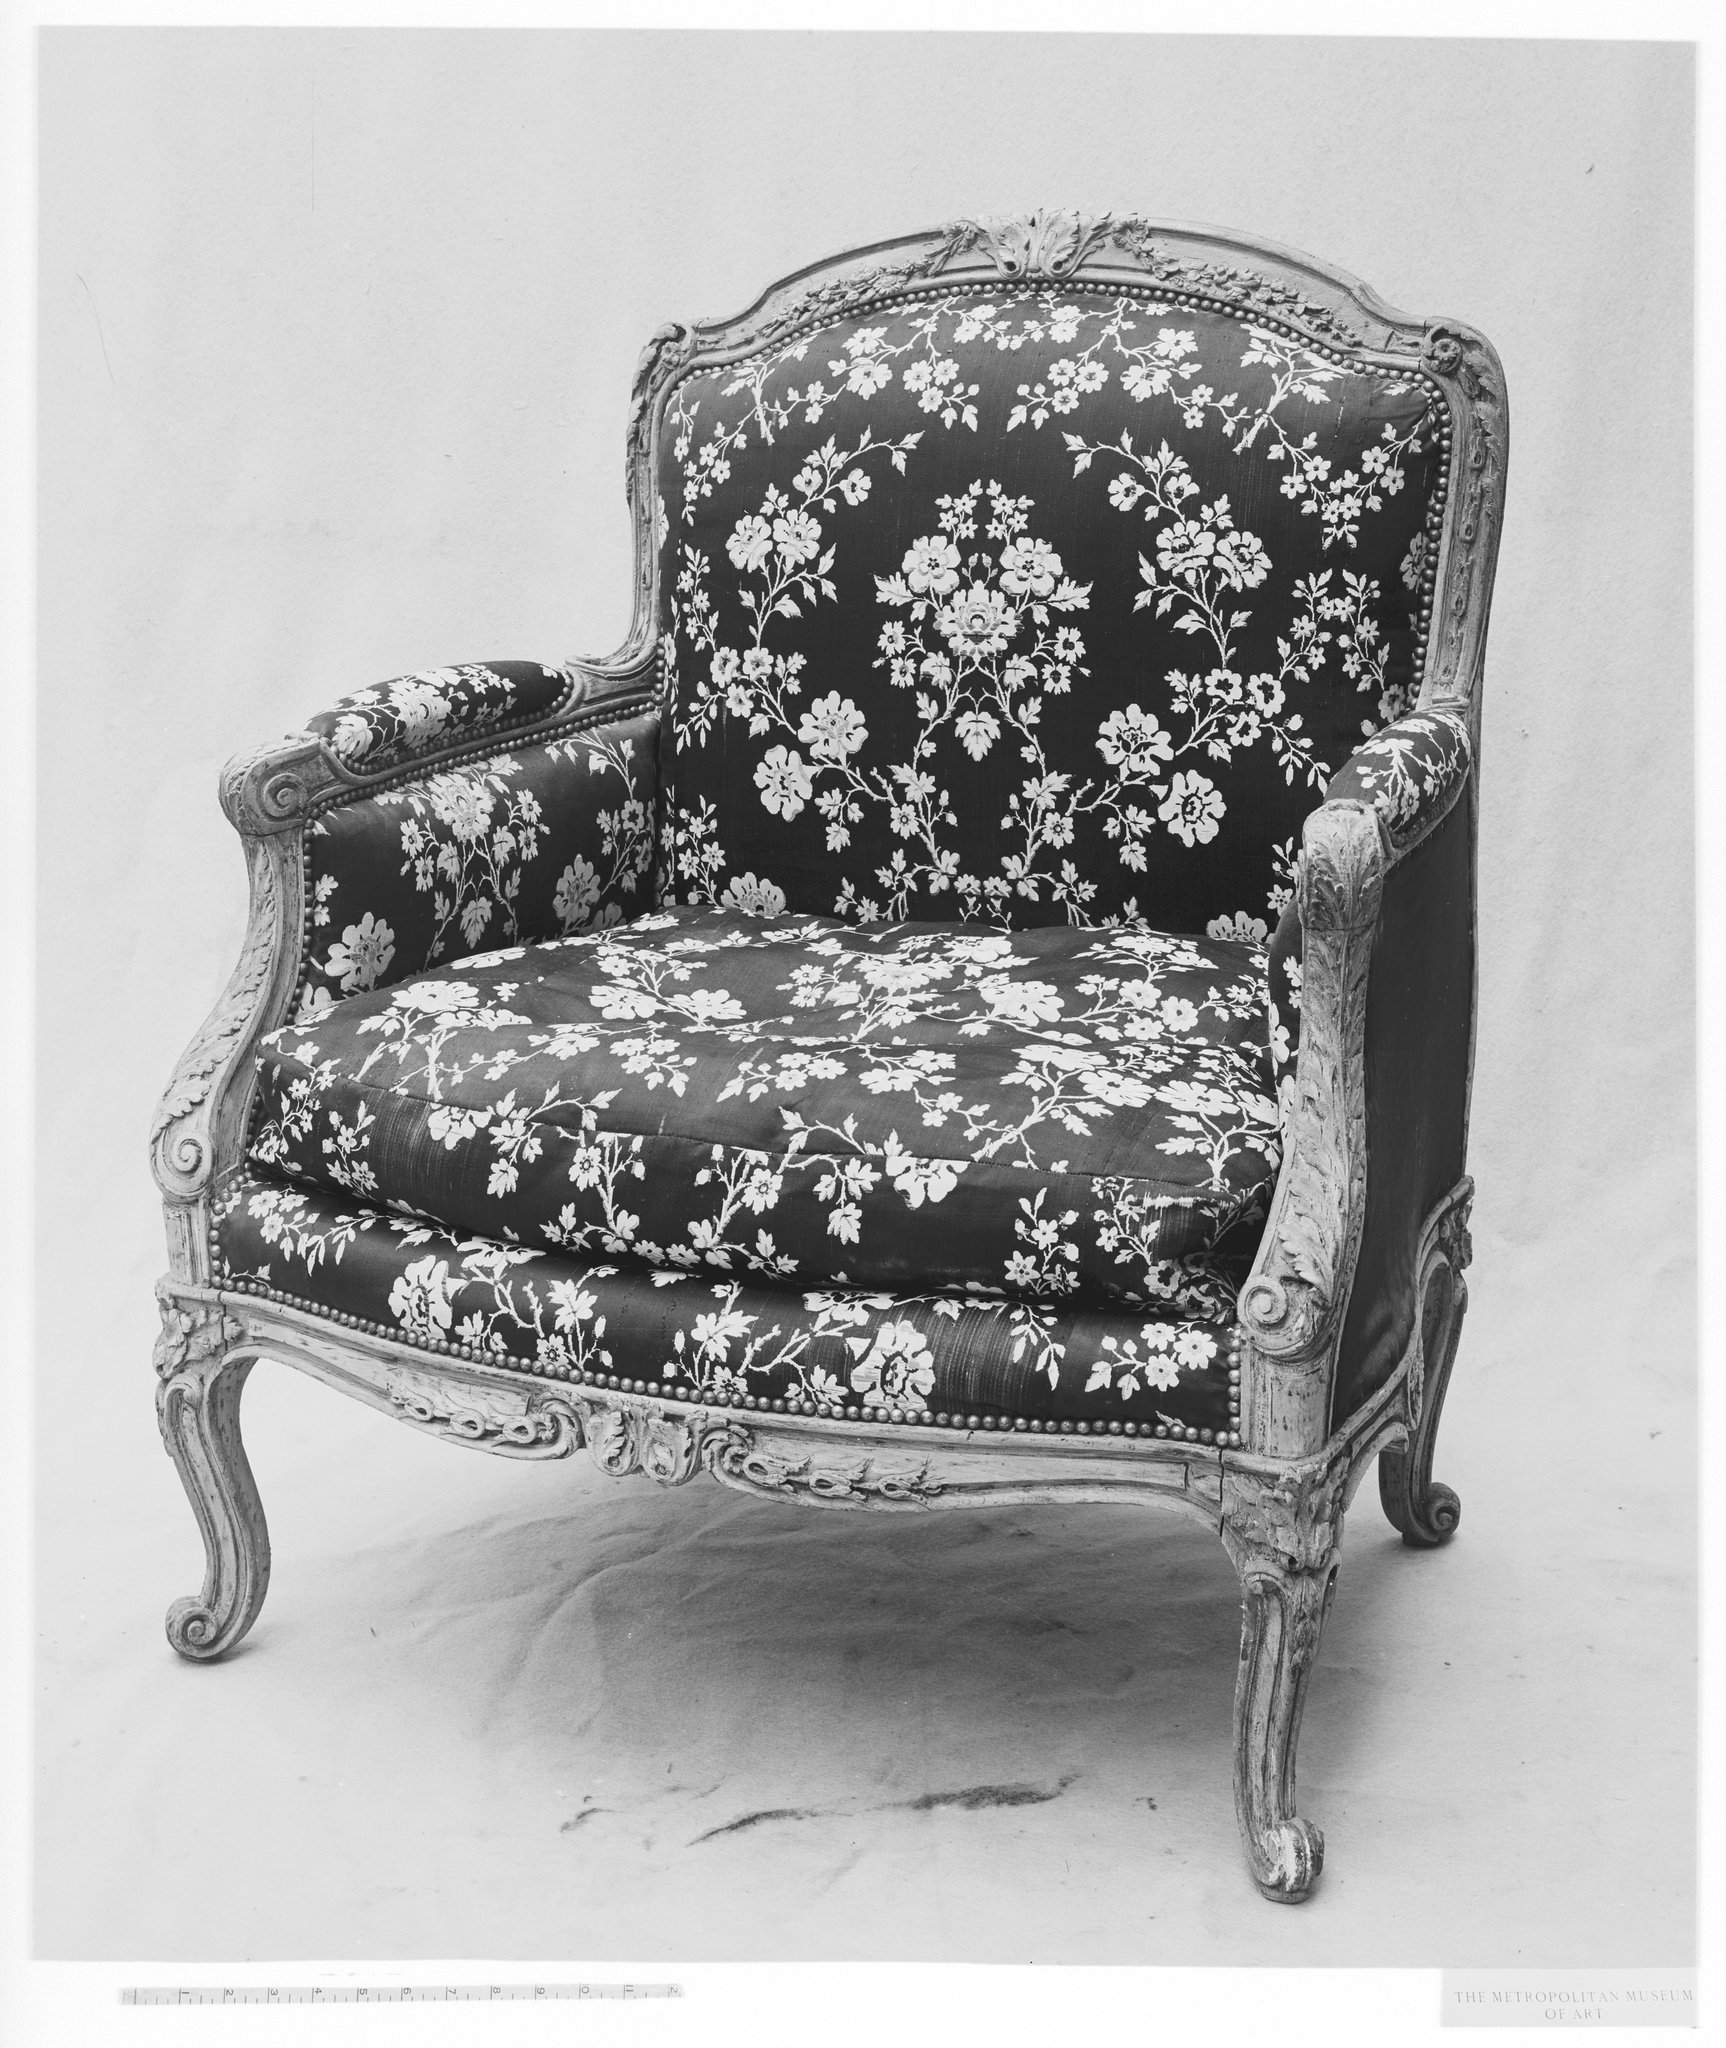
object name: armchair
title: Armchair (bergère)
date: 1760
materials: wood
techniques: carving